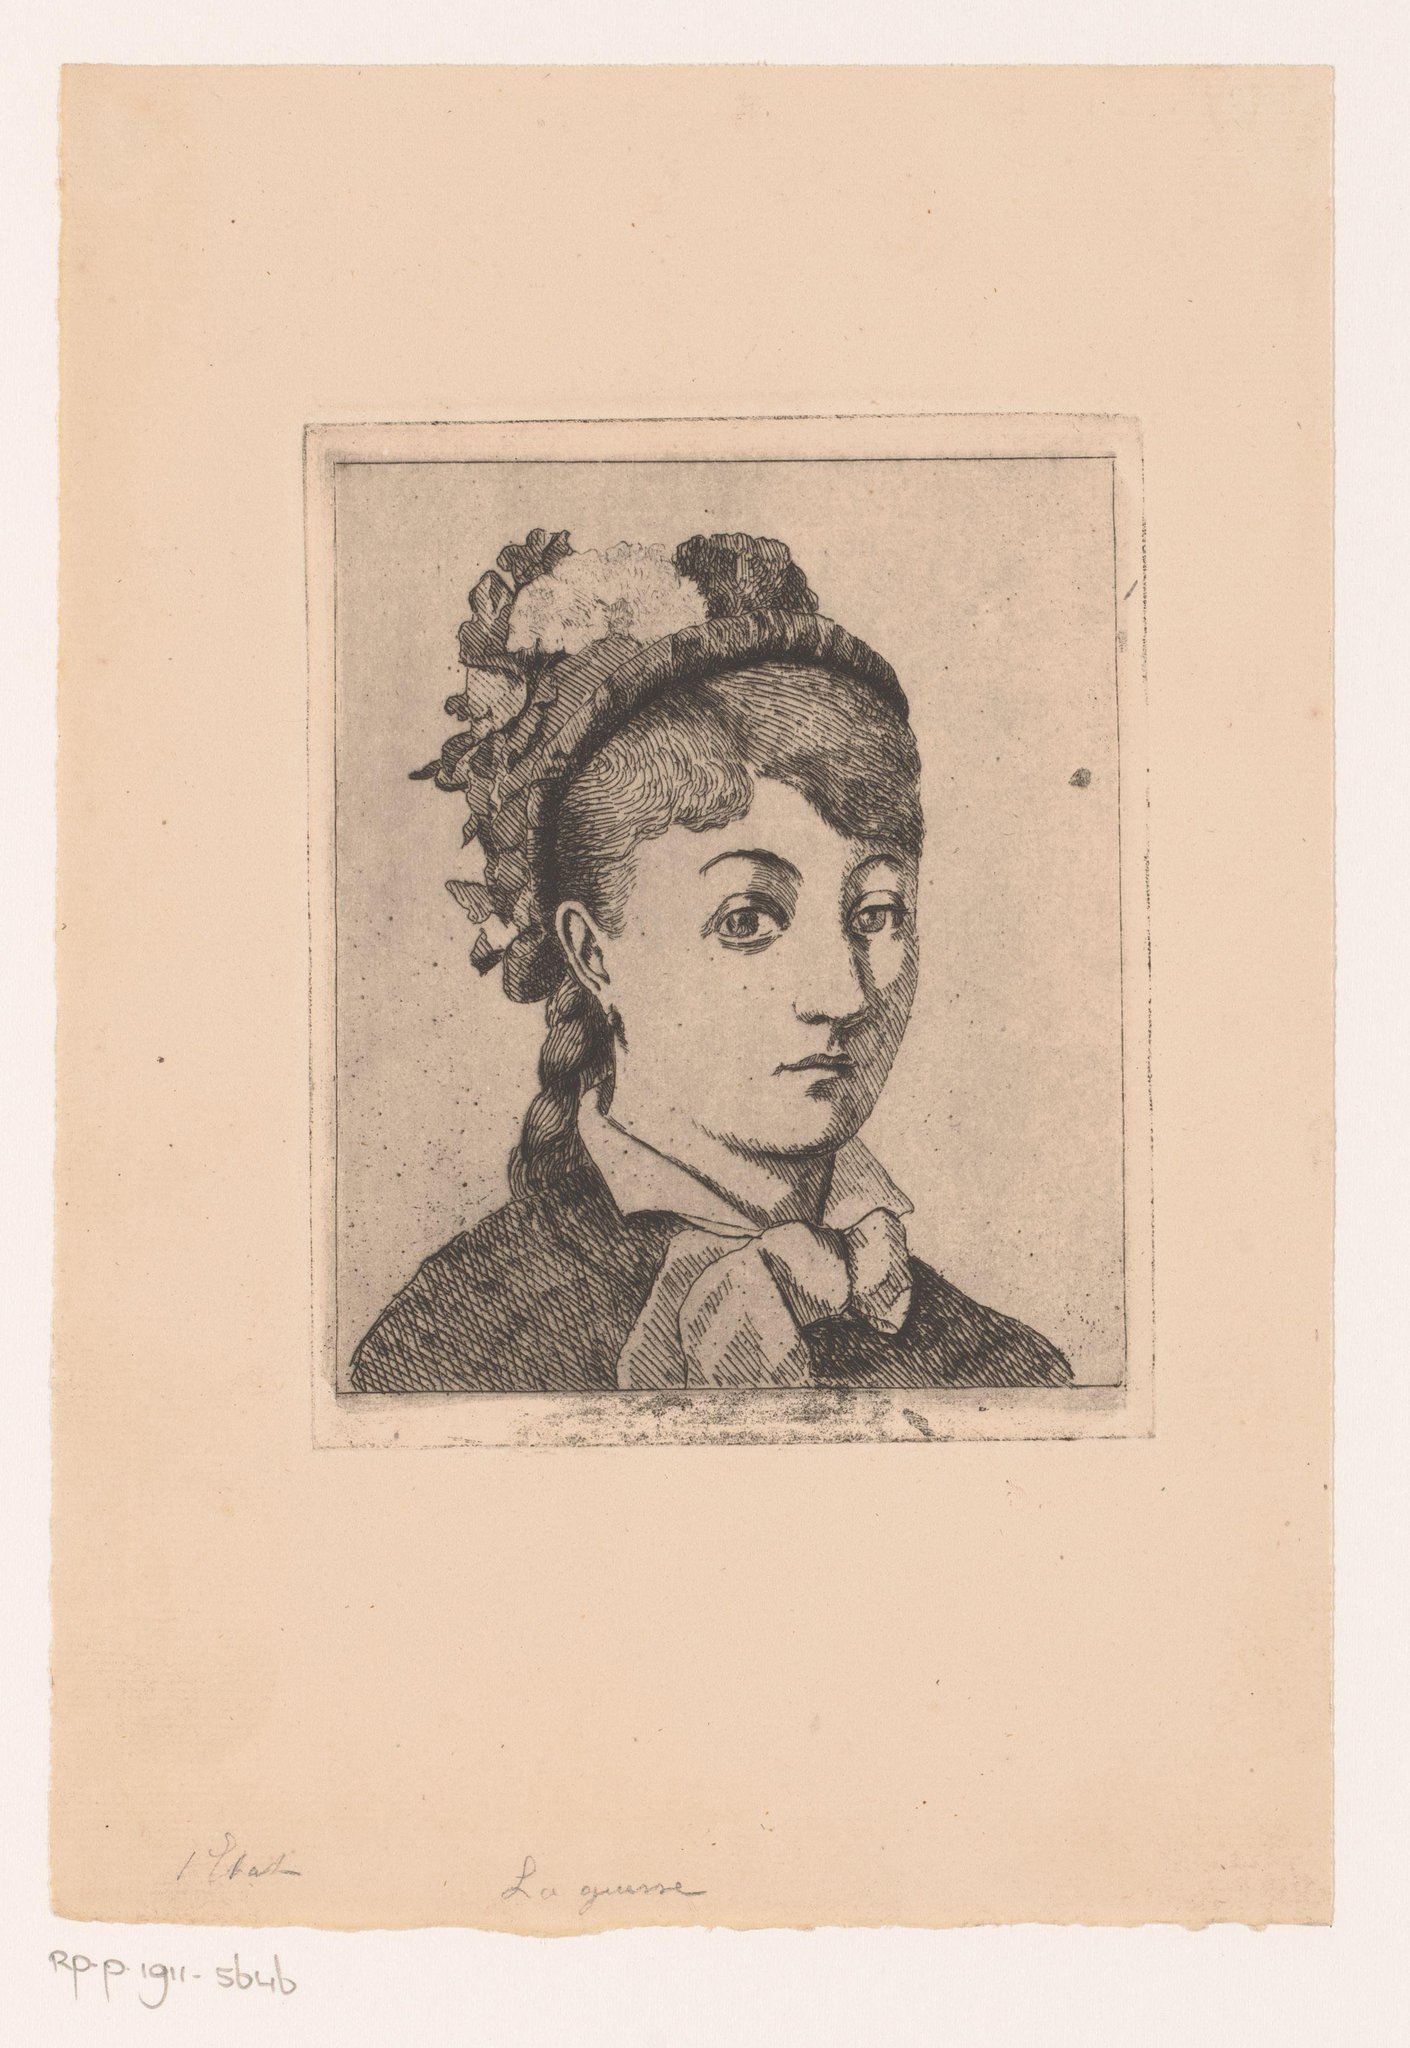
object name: print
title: Portret van een onbekende jonge vrouw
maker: g. laguesse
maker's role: print maker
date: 1850-1911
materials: paper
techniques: drypoint, etching, intaglio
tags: anonymous historical person portrayed alone - bb - woman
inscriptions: collector's mark: Lugt 2228, annotation: ‘1 Etat’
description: Sterfdatum prentmaker onbekend. Derhalve is voor bepaling van de rechten van dit object de verwervingsdatum aangehouden.